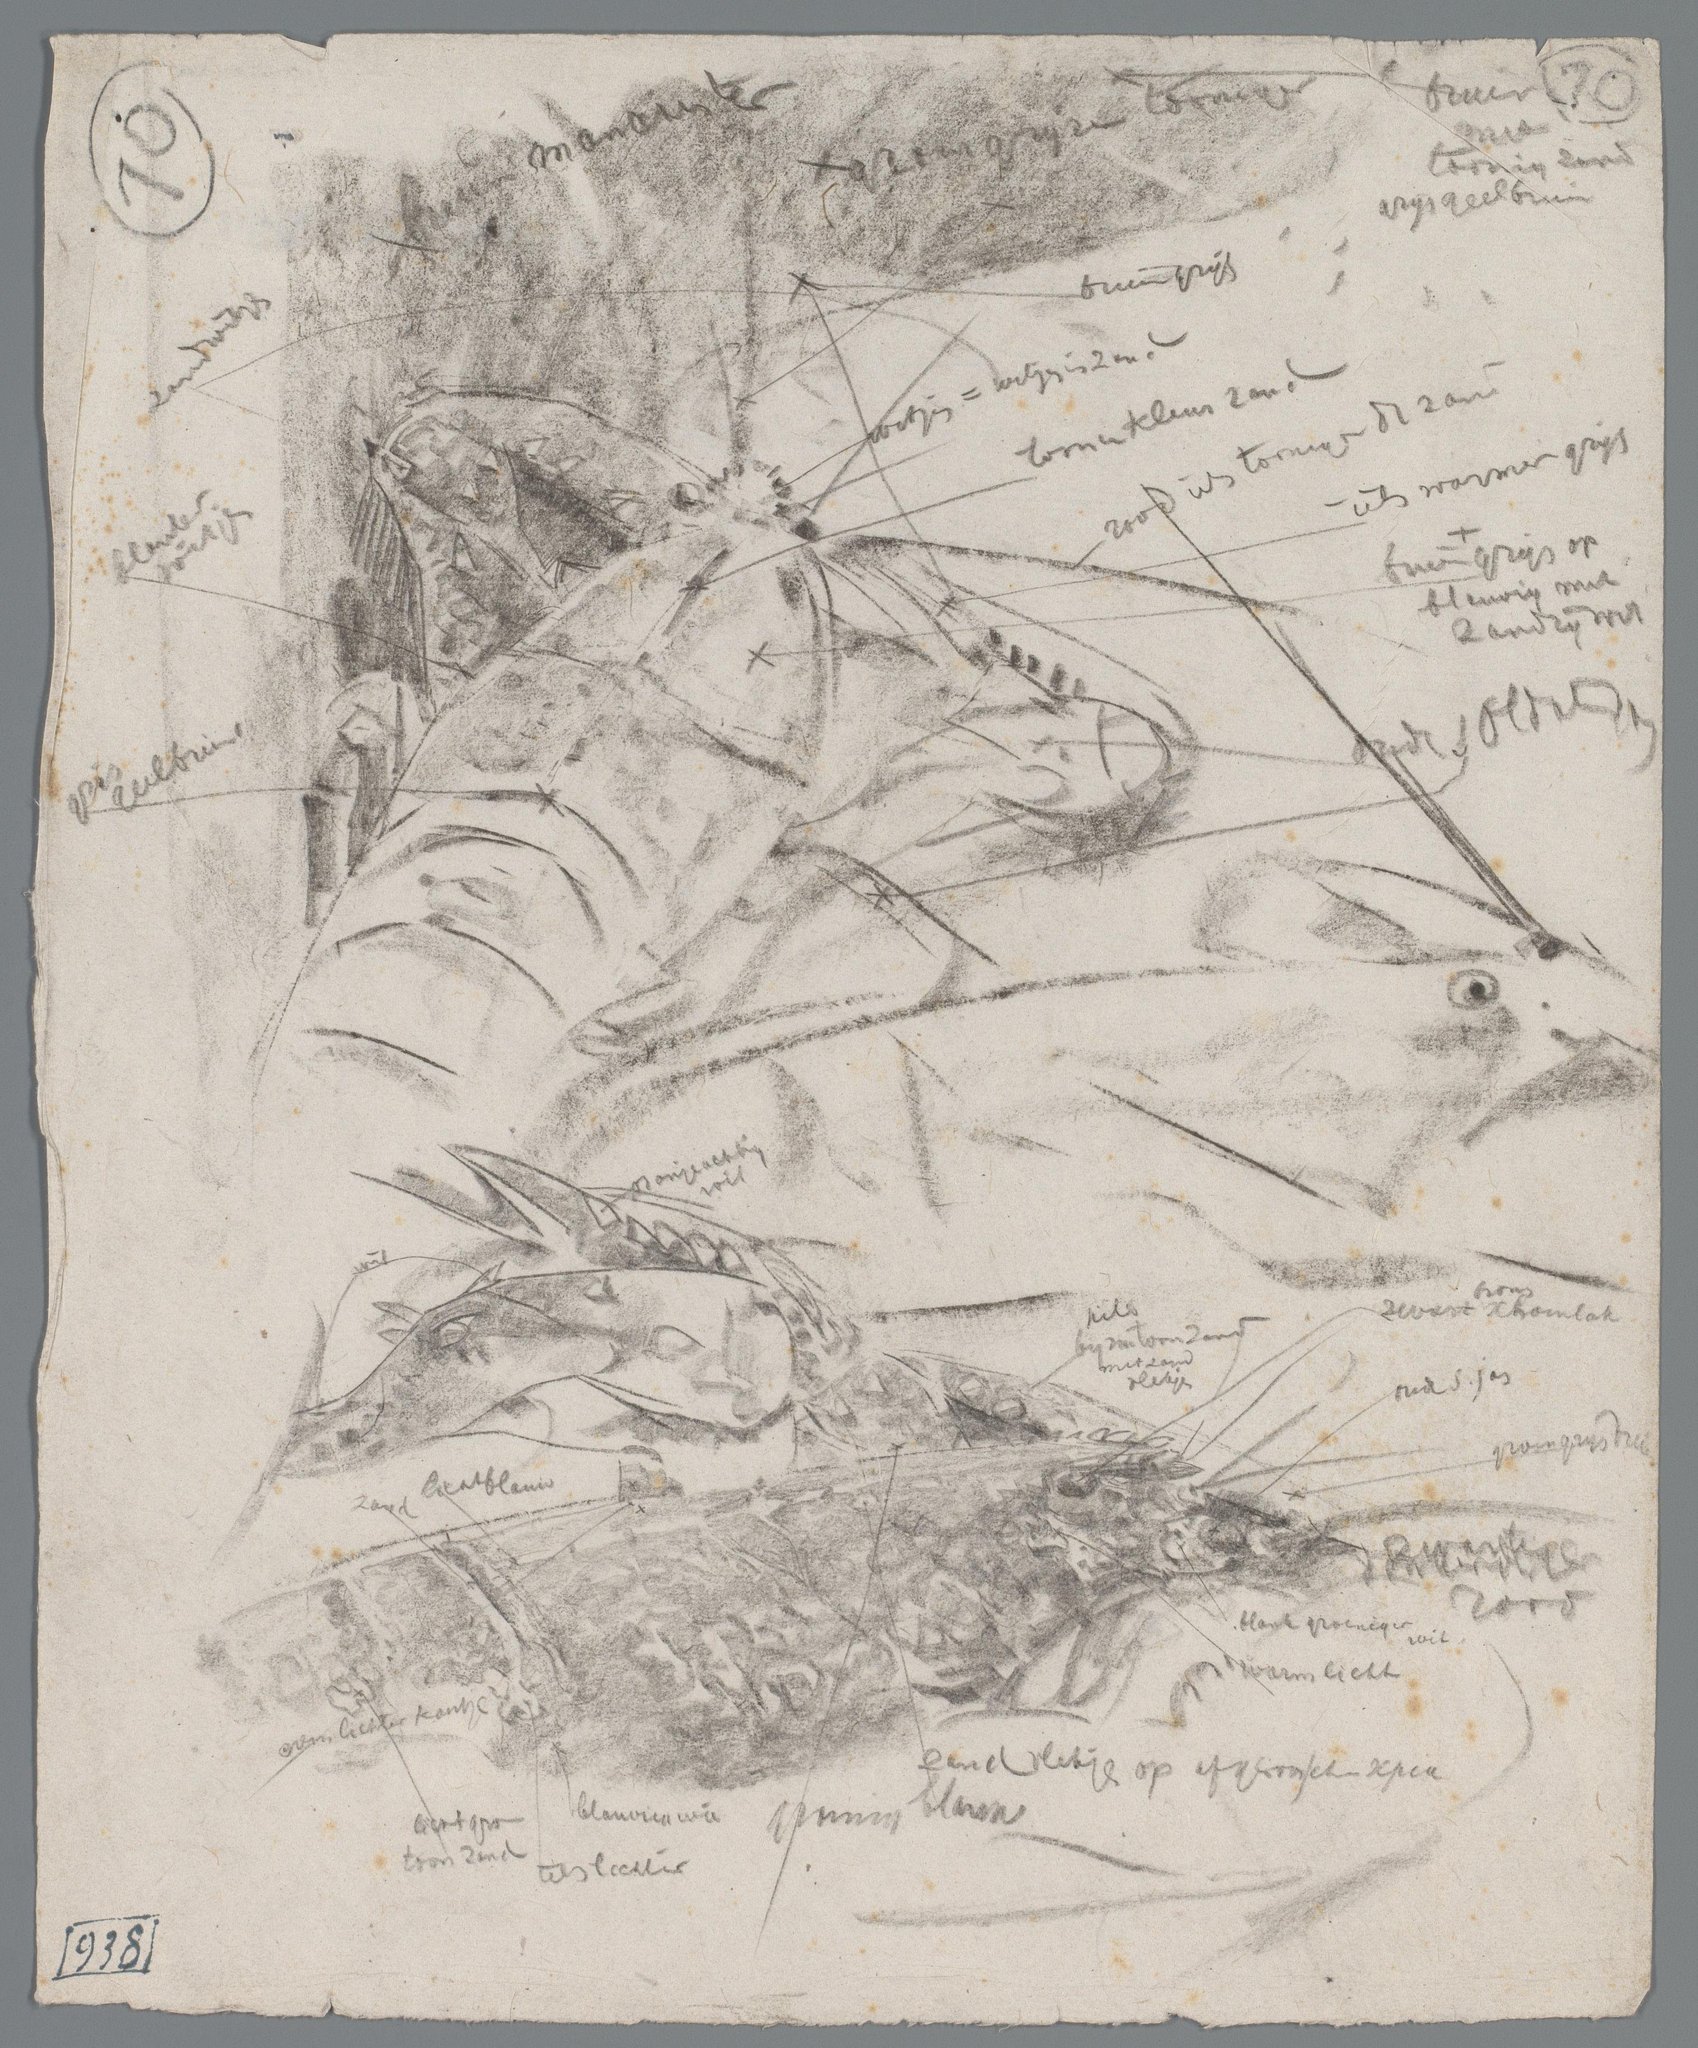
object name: drawing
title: Studies van kreeften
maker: gerrit willem dijsselhof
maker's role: designer, draughtsman, print maker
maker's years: 1866-1924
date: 1876-1924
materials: chalk, paper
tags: crustaceans: lobster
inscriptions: number: ‘70’, number: ‘938’